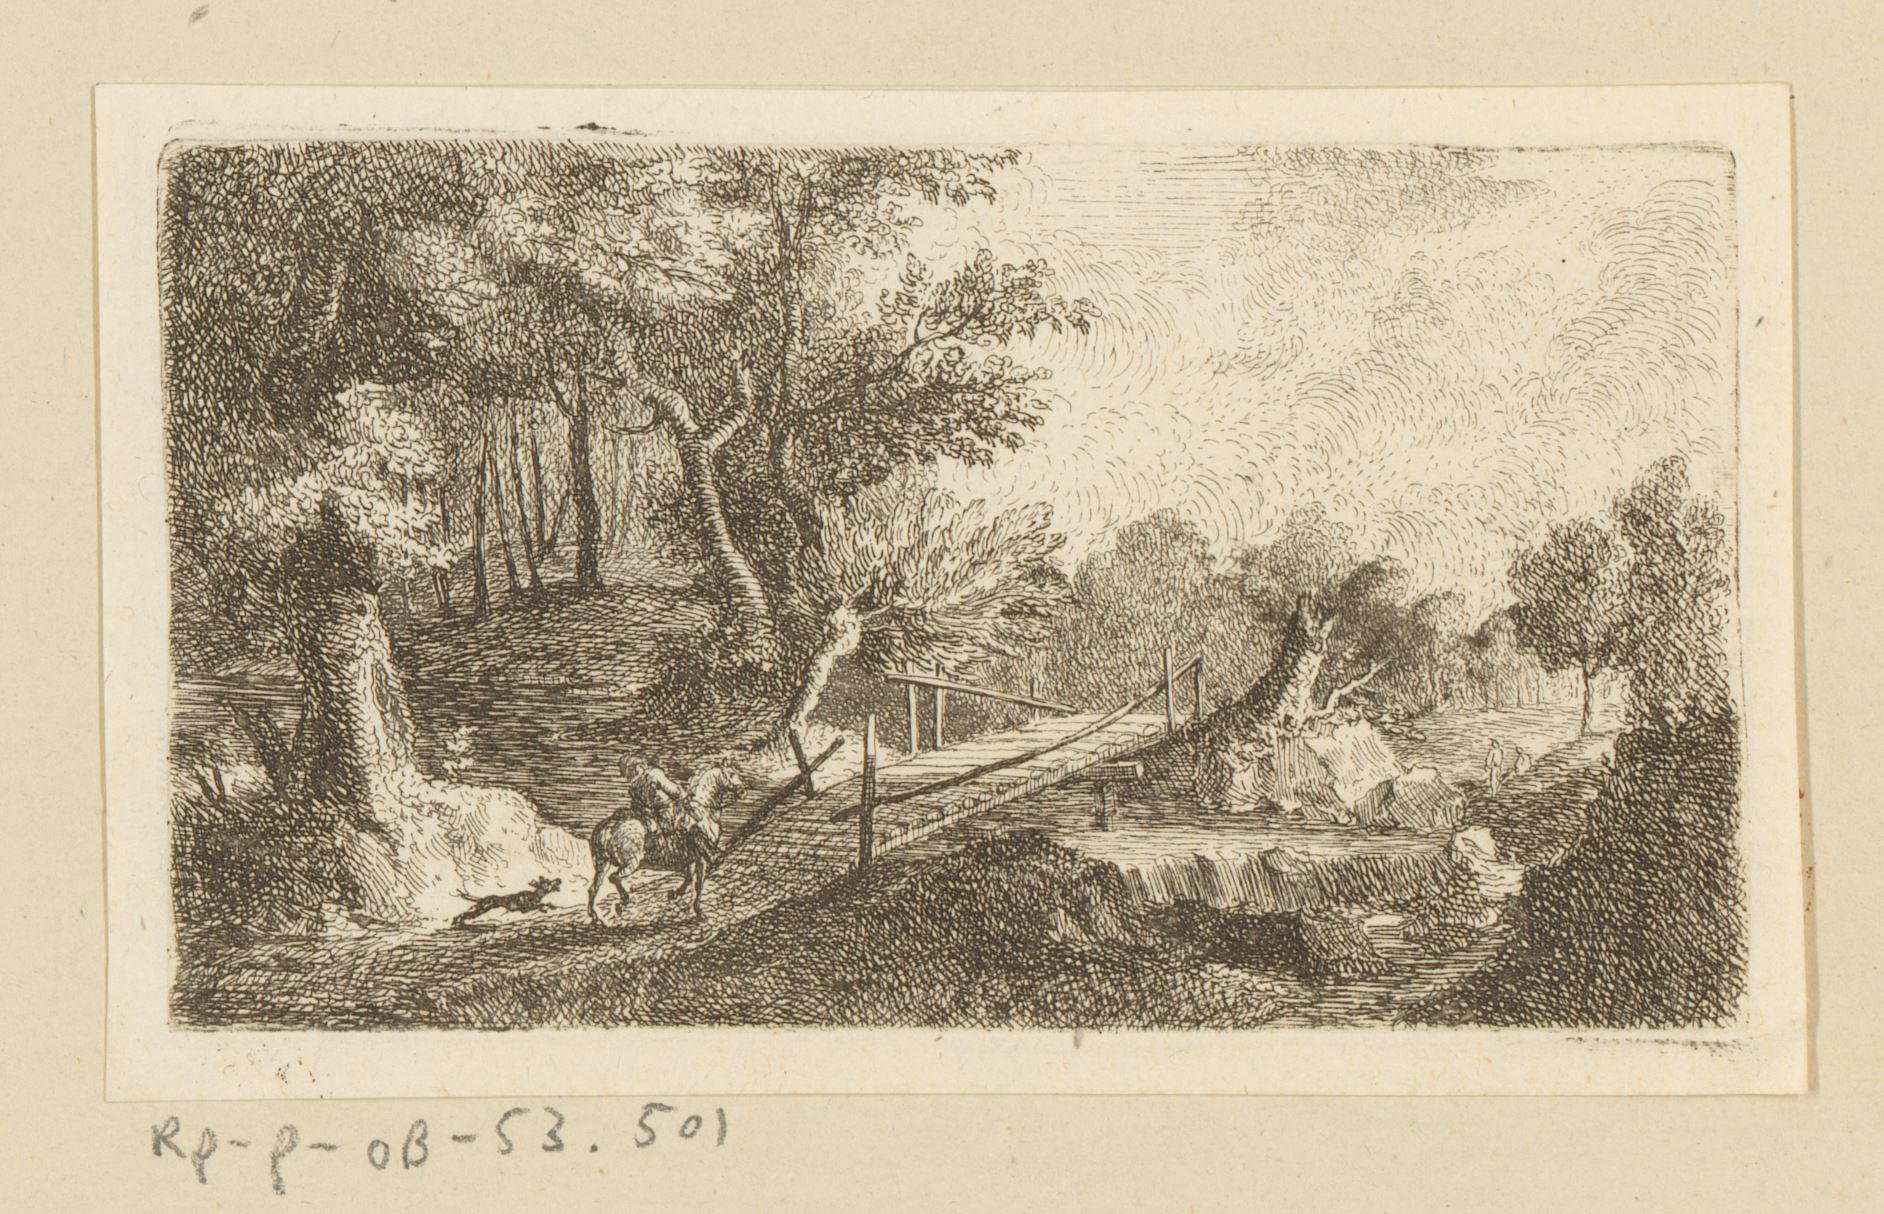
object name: print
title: Ruiter bij houten brug in bos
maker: johann andreas benjamin nothnagel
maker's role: print maker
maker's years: 1729-1804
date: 1739-1804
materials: paper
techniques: etching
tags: landscapes with waters, waterscapes, seascapes (in the temperate zone)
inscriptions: collector's mark: Lugt 240